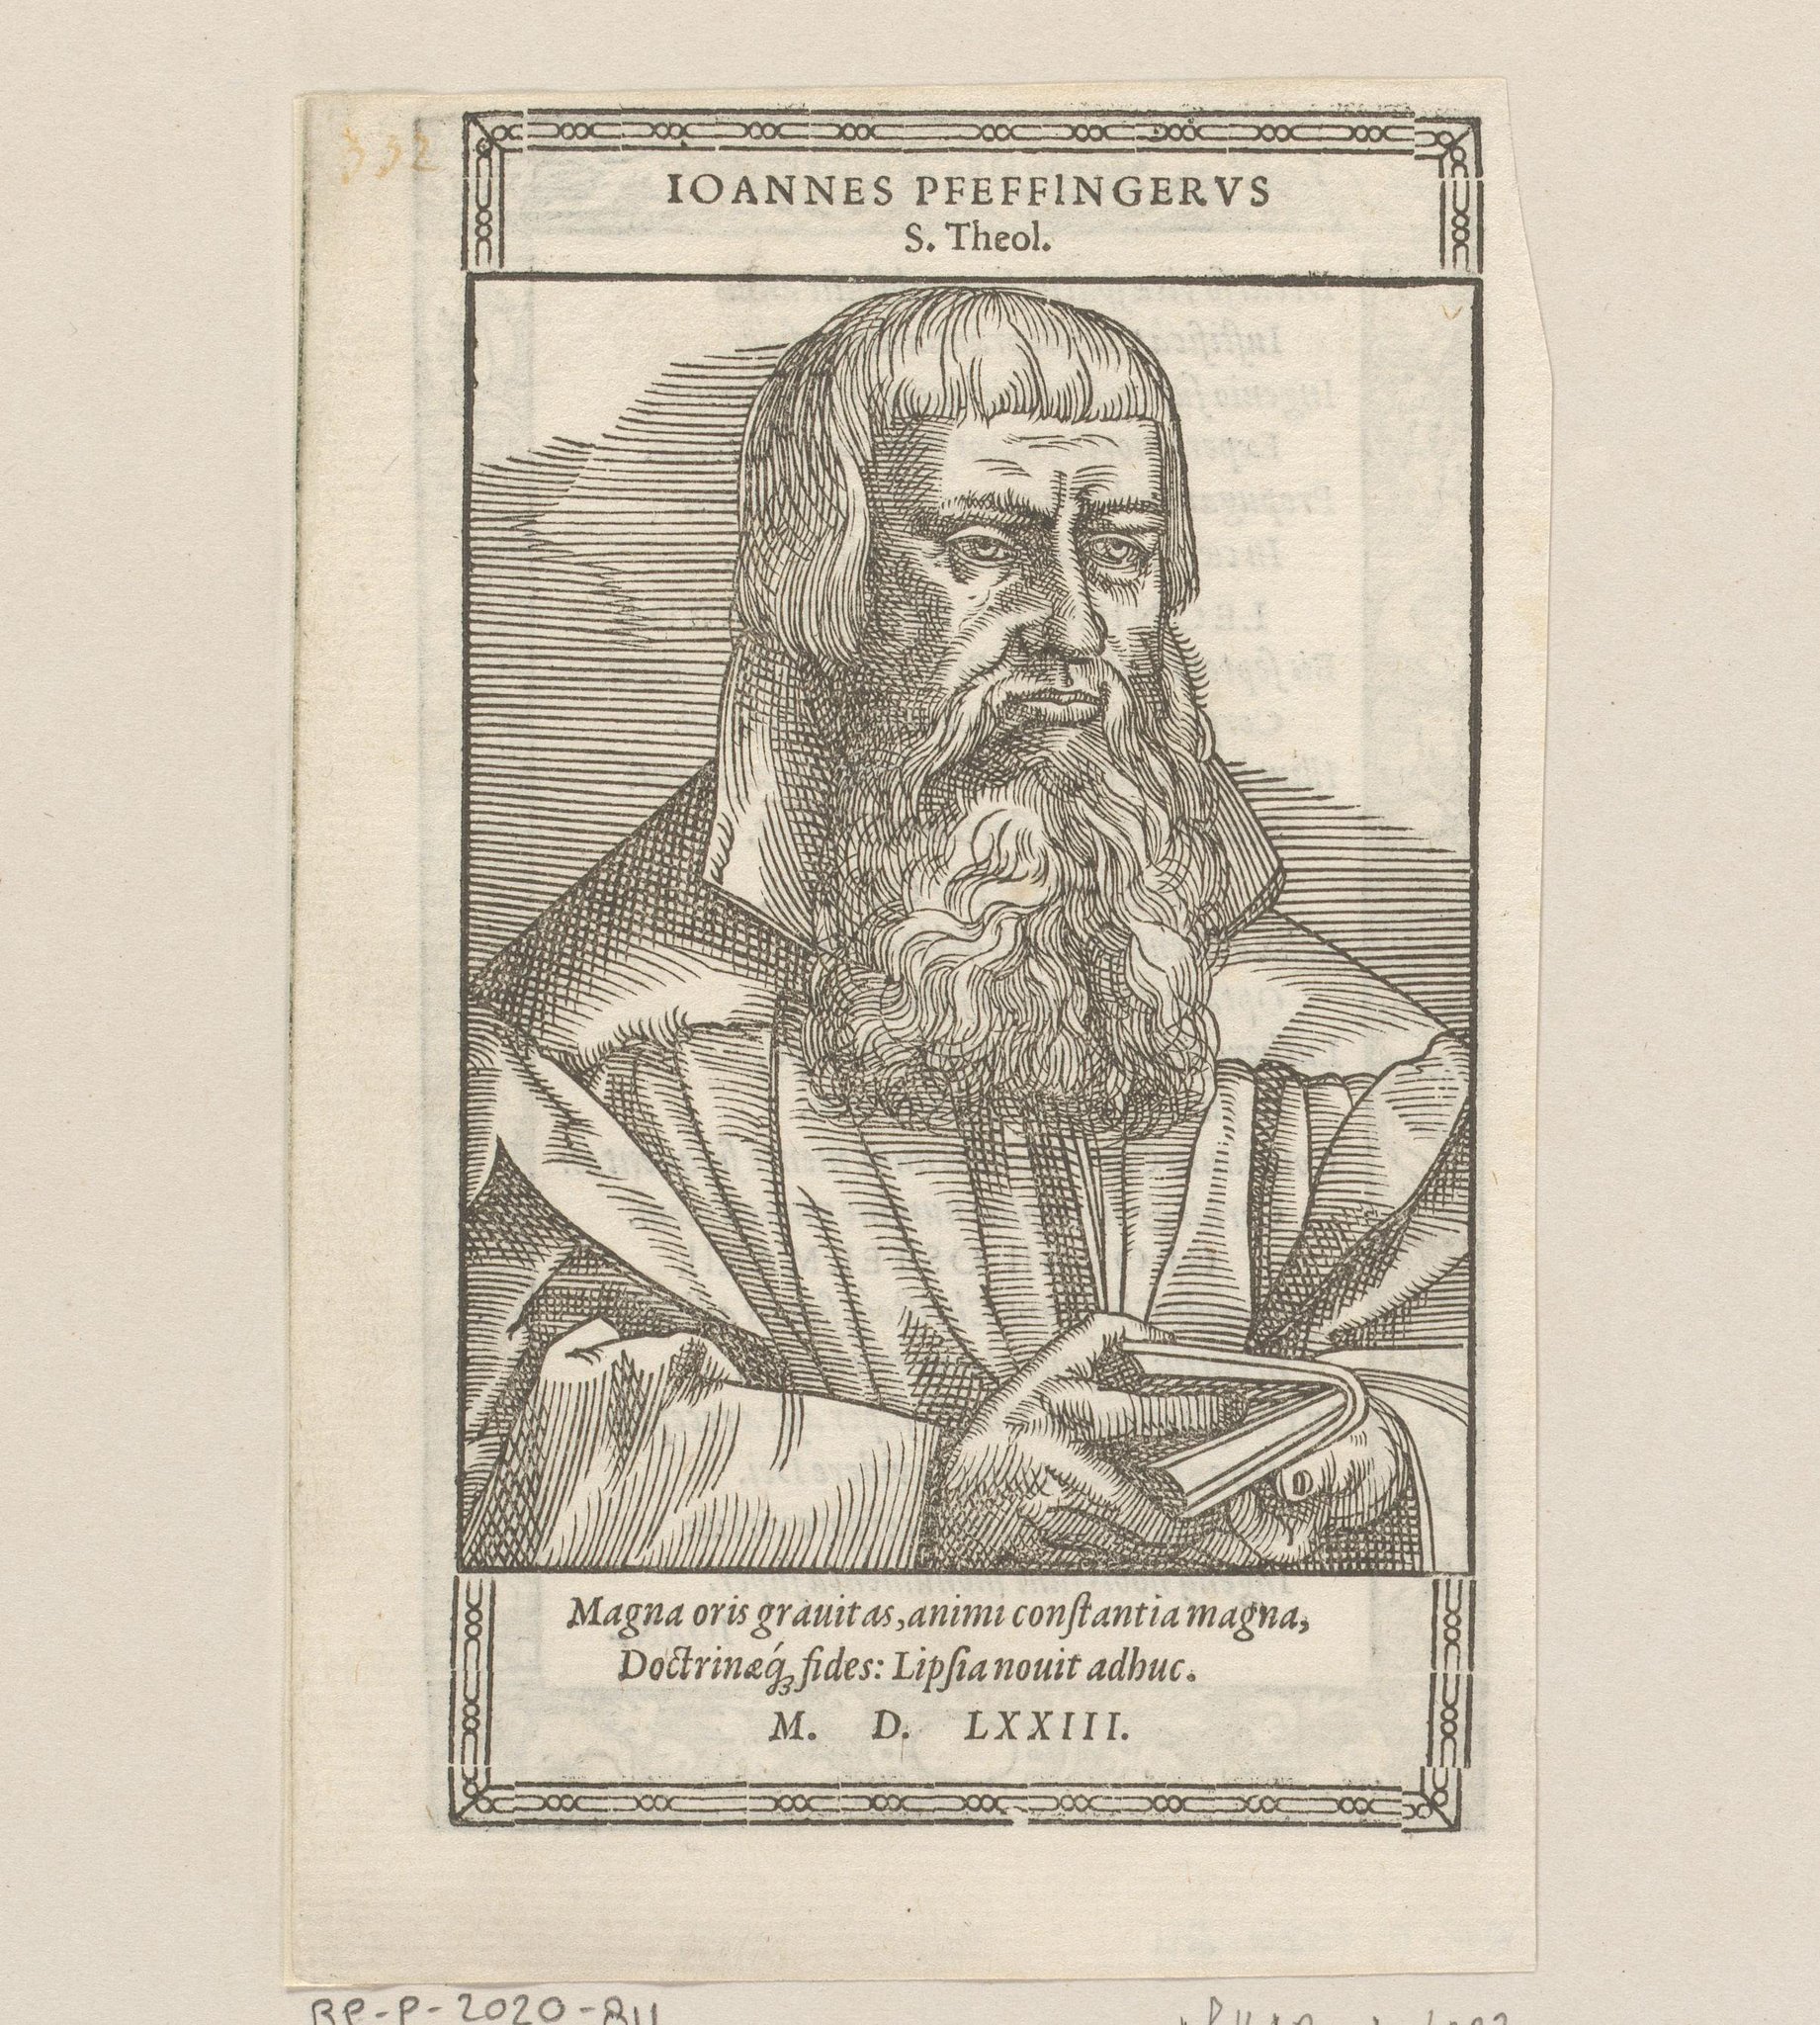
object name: print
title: Portret van Johann Pfeffinger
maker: bernhard jobin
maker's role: printer, publisher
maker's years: 1545-1593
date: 1587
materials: paper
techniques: letterpress printing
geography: straatsburg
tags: theologian, historical persons, book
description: Prent uit: Reusner, Nikolaus. Icones sive imagines virorum literis illustrium (...). Straatsburg: Bernhard Jobin, 1587. Prent ook gebruikt in de Duitse editie, uitgegeven in hetzelfde jaar, en de 1590-editie. Prent ook gebruikt in latere publicaties.